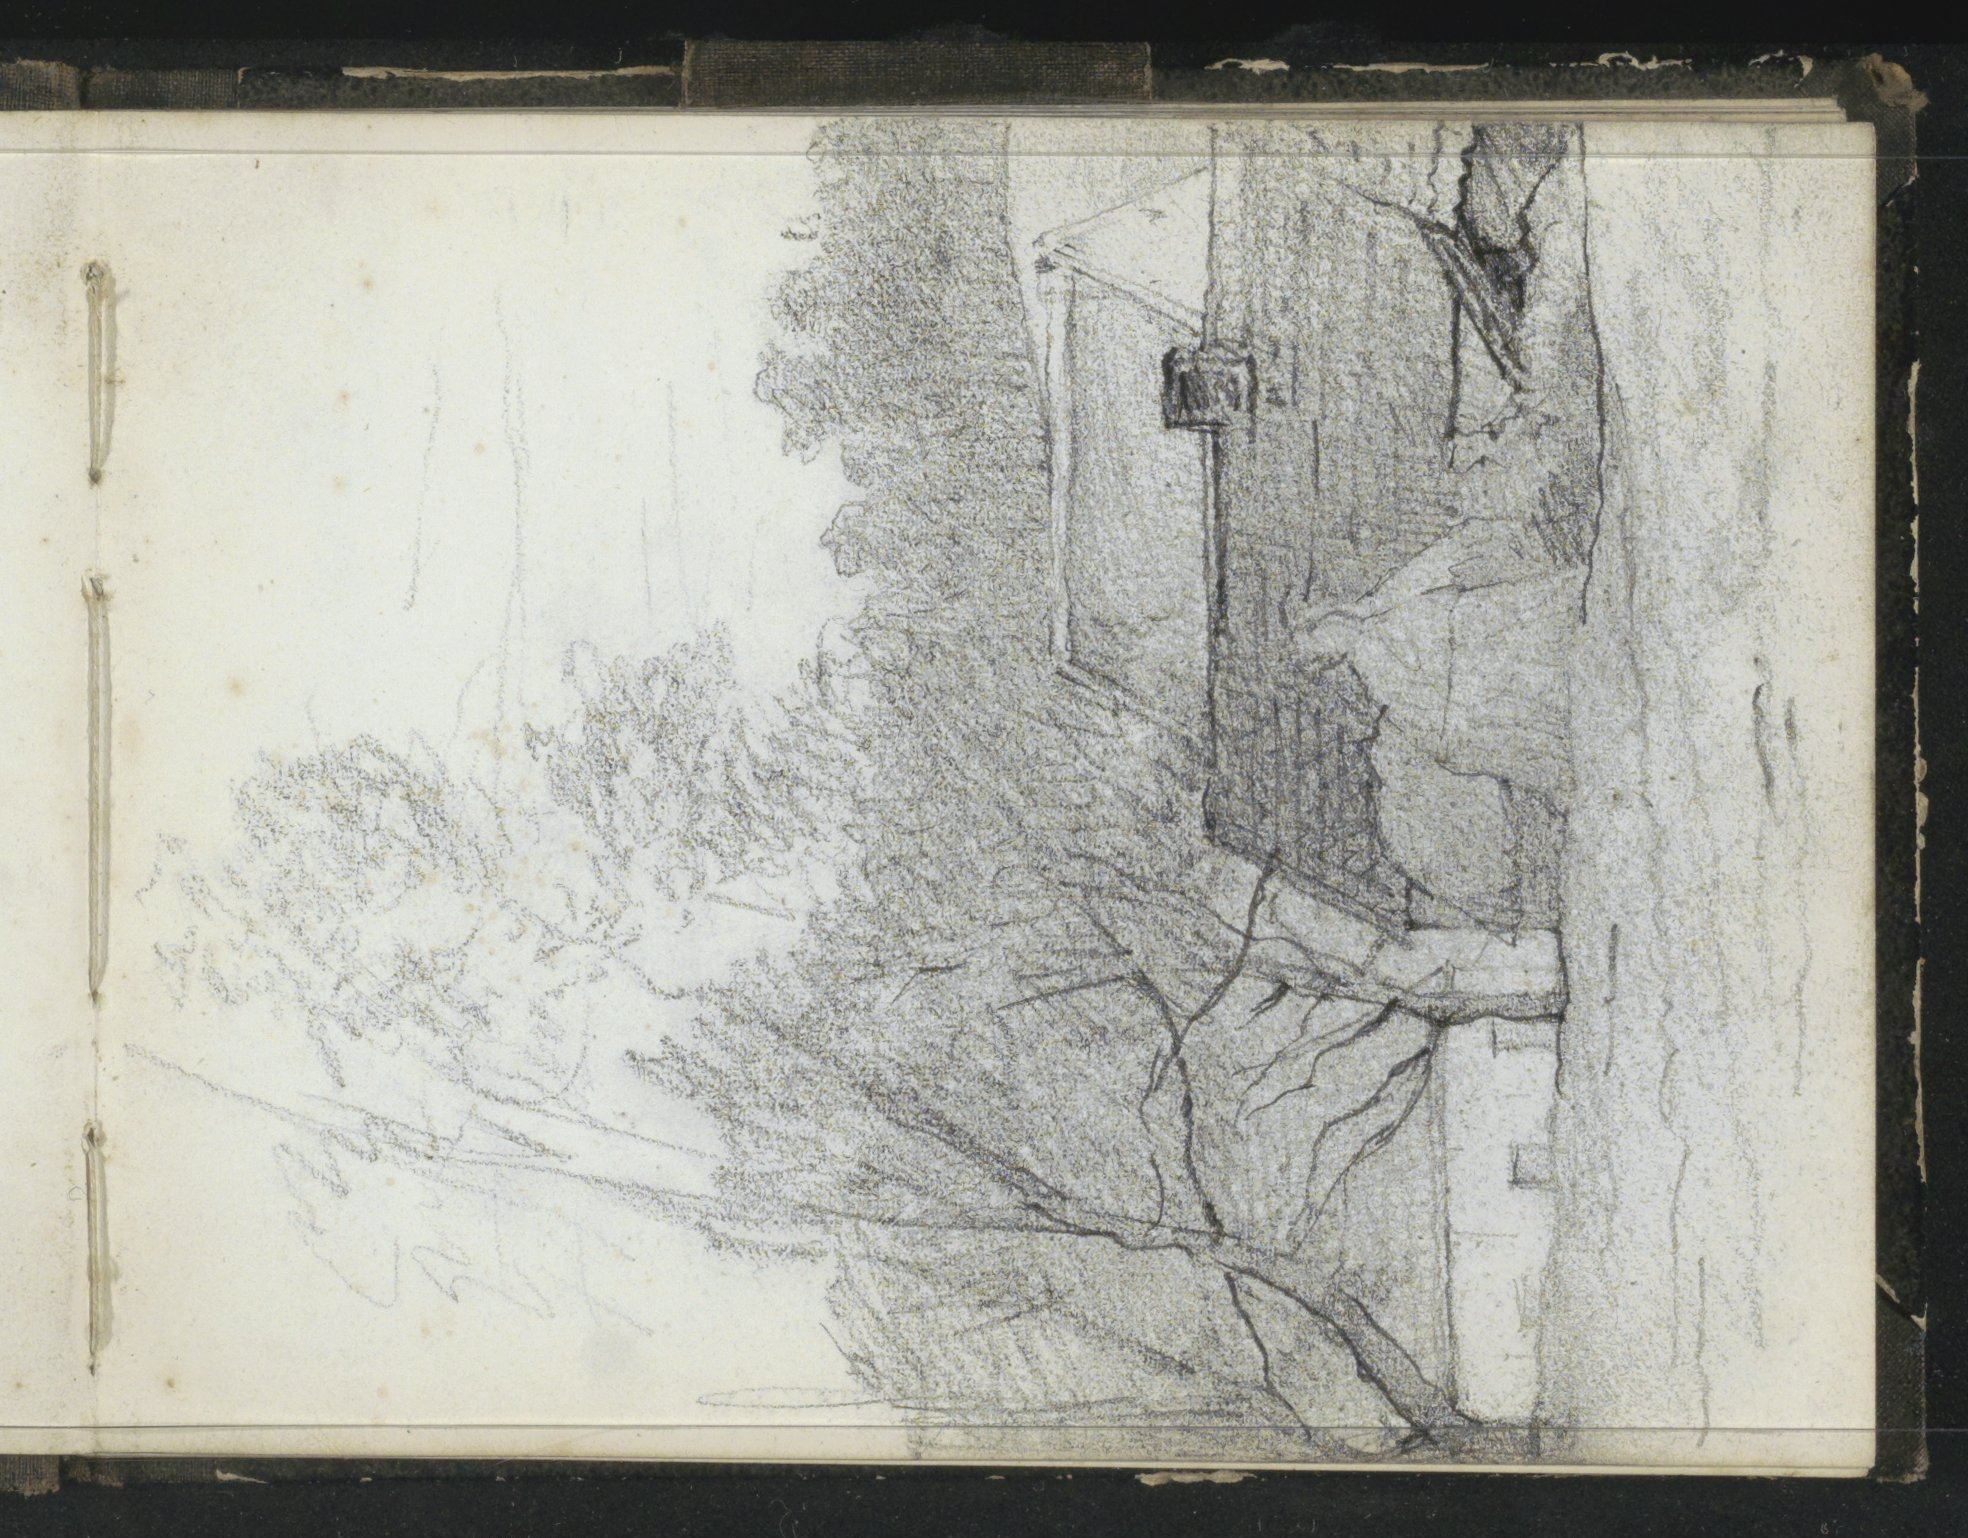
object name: sketchbook leaf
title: Hooibalen naast een boerderij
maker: theo hanrath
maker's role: draughtsman, painter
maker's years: 1853-1883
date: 1879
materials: paper, pencil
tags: hay-stack, farm (building)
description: Blad 3 recto uit een schetsboek met 27 bladen.